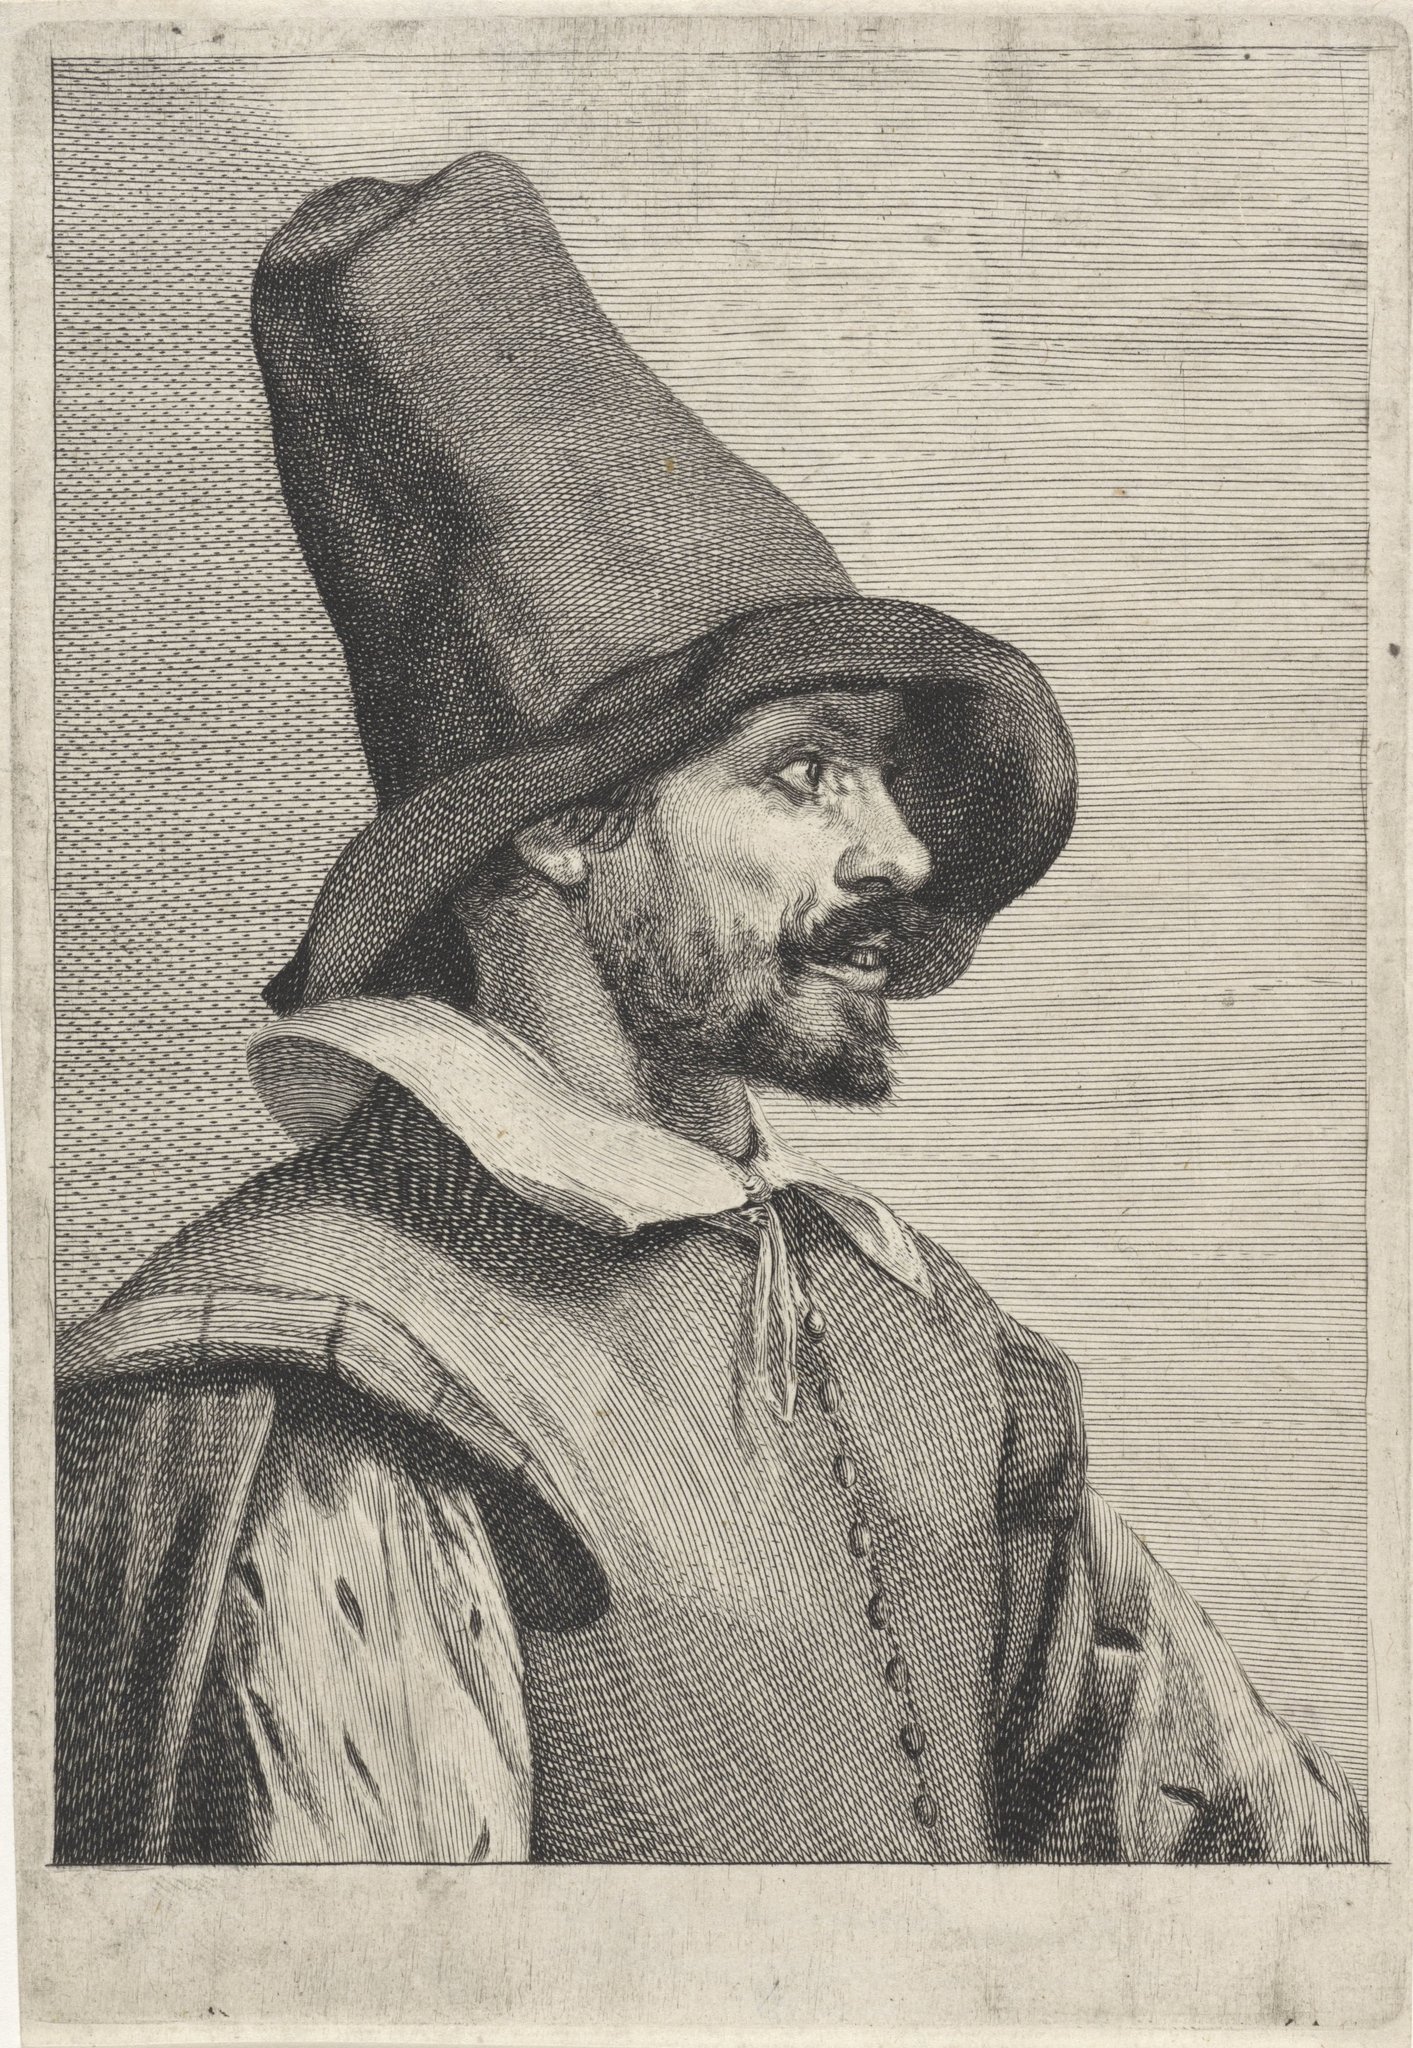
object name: print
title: Portret van Jan Jansz, alias Jan de Dood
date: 1638-1658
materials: paper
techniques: engraving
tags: head-gear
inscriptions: collector's mark: Lugt 240